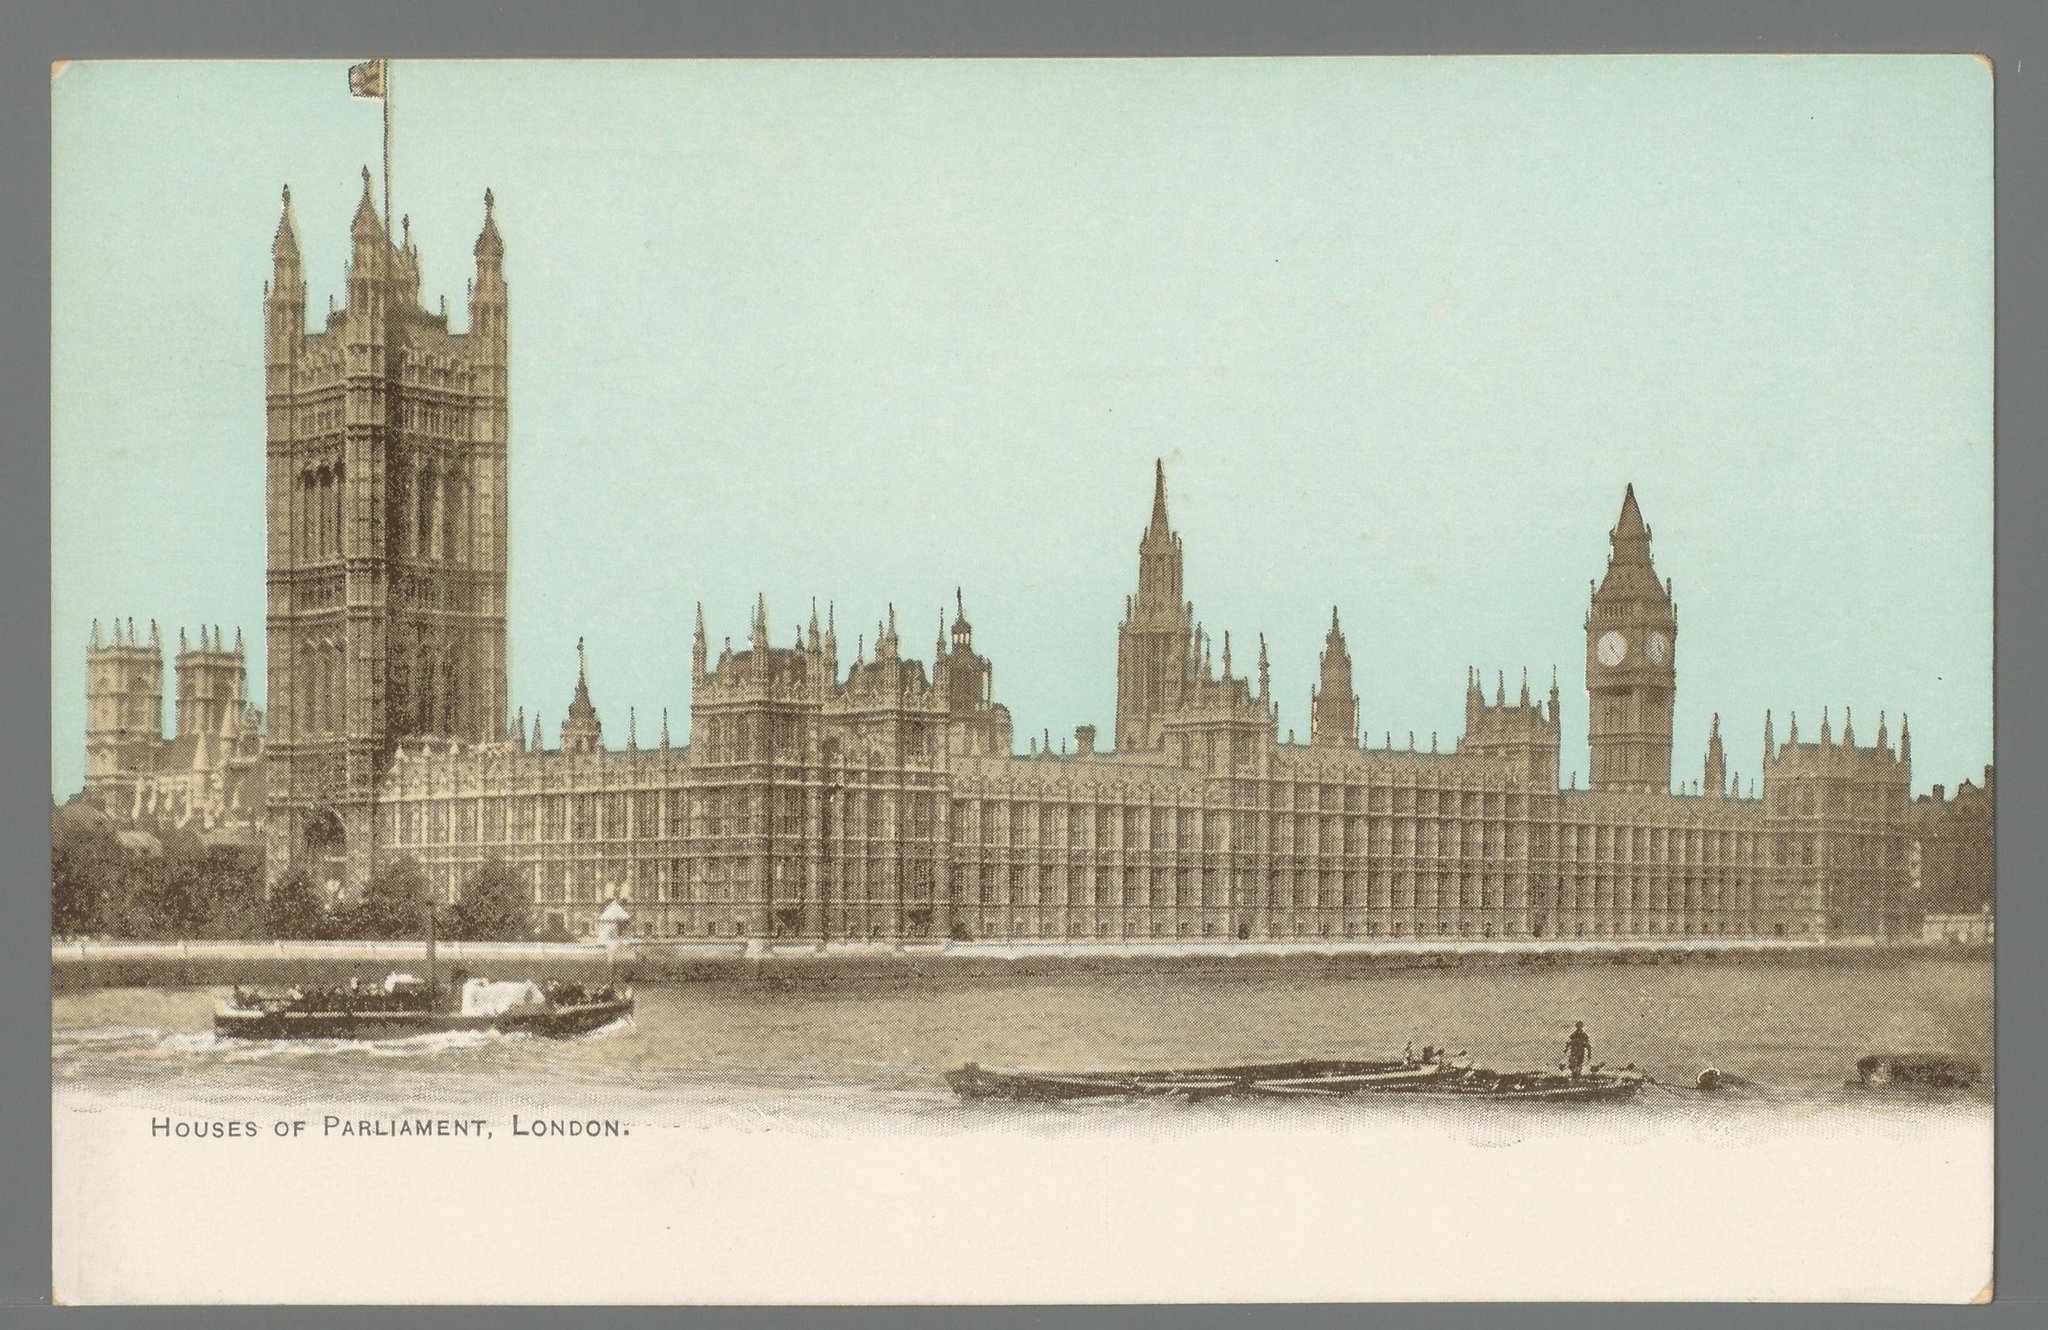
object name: photomechanical print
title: Houses of Parliament, London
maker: Anonymous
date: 1902-1930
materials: cardboard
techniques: lithograph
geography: london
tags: canals, waters (in city), thames